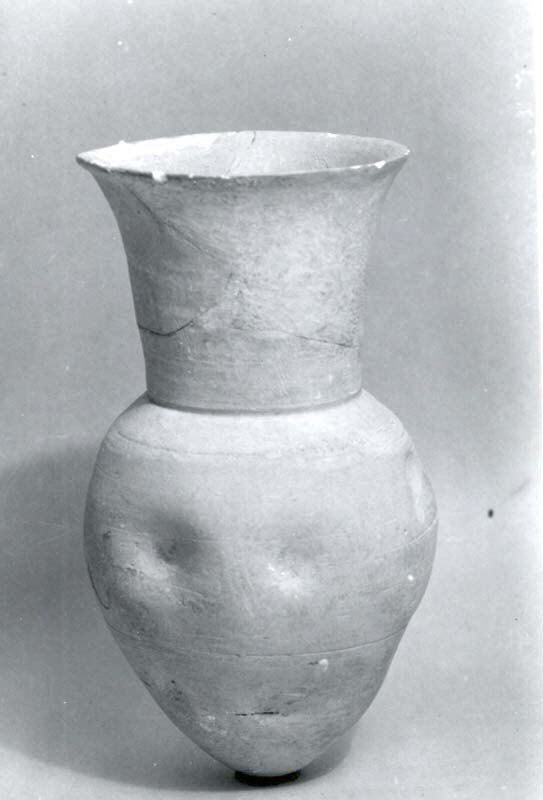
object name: beaker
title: Palace Ware beaker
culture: assyrian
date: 800-601 BCE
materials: ceramic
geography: mesopotamia